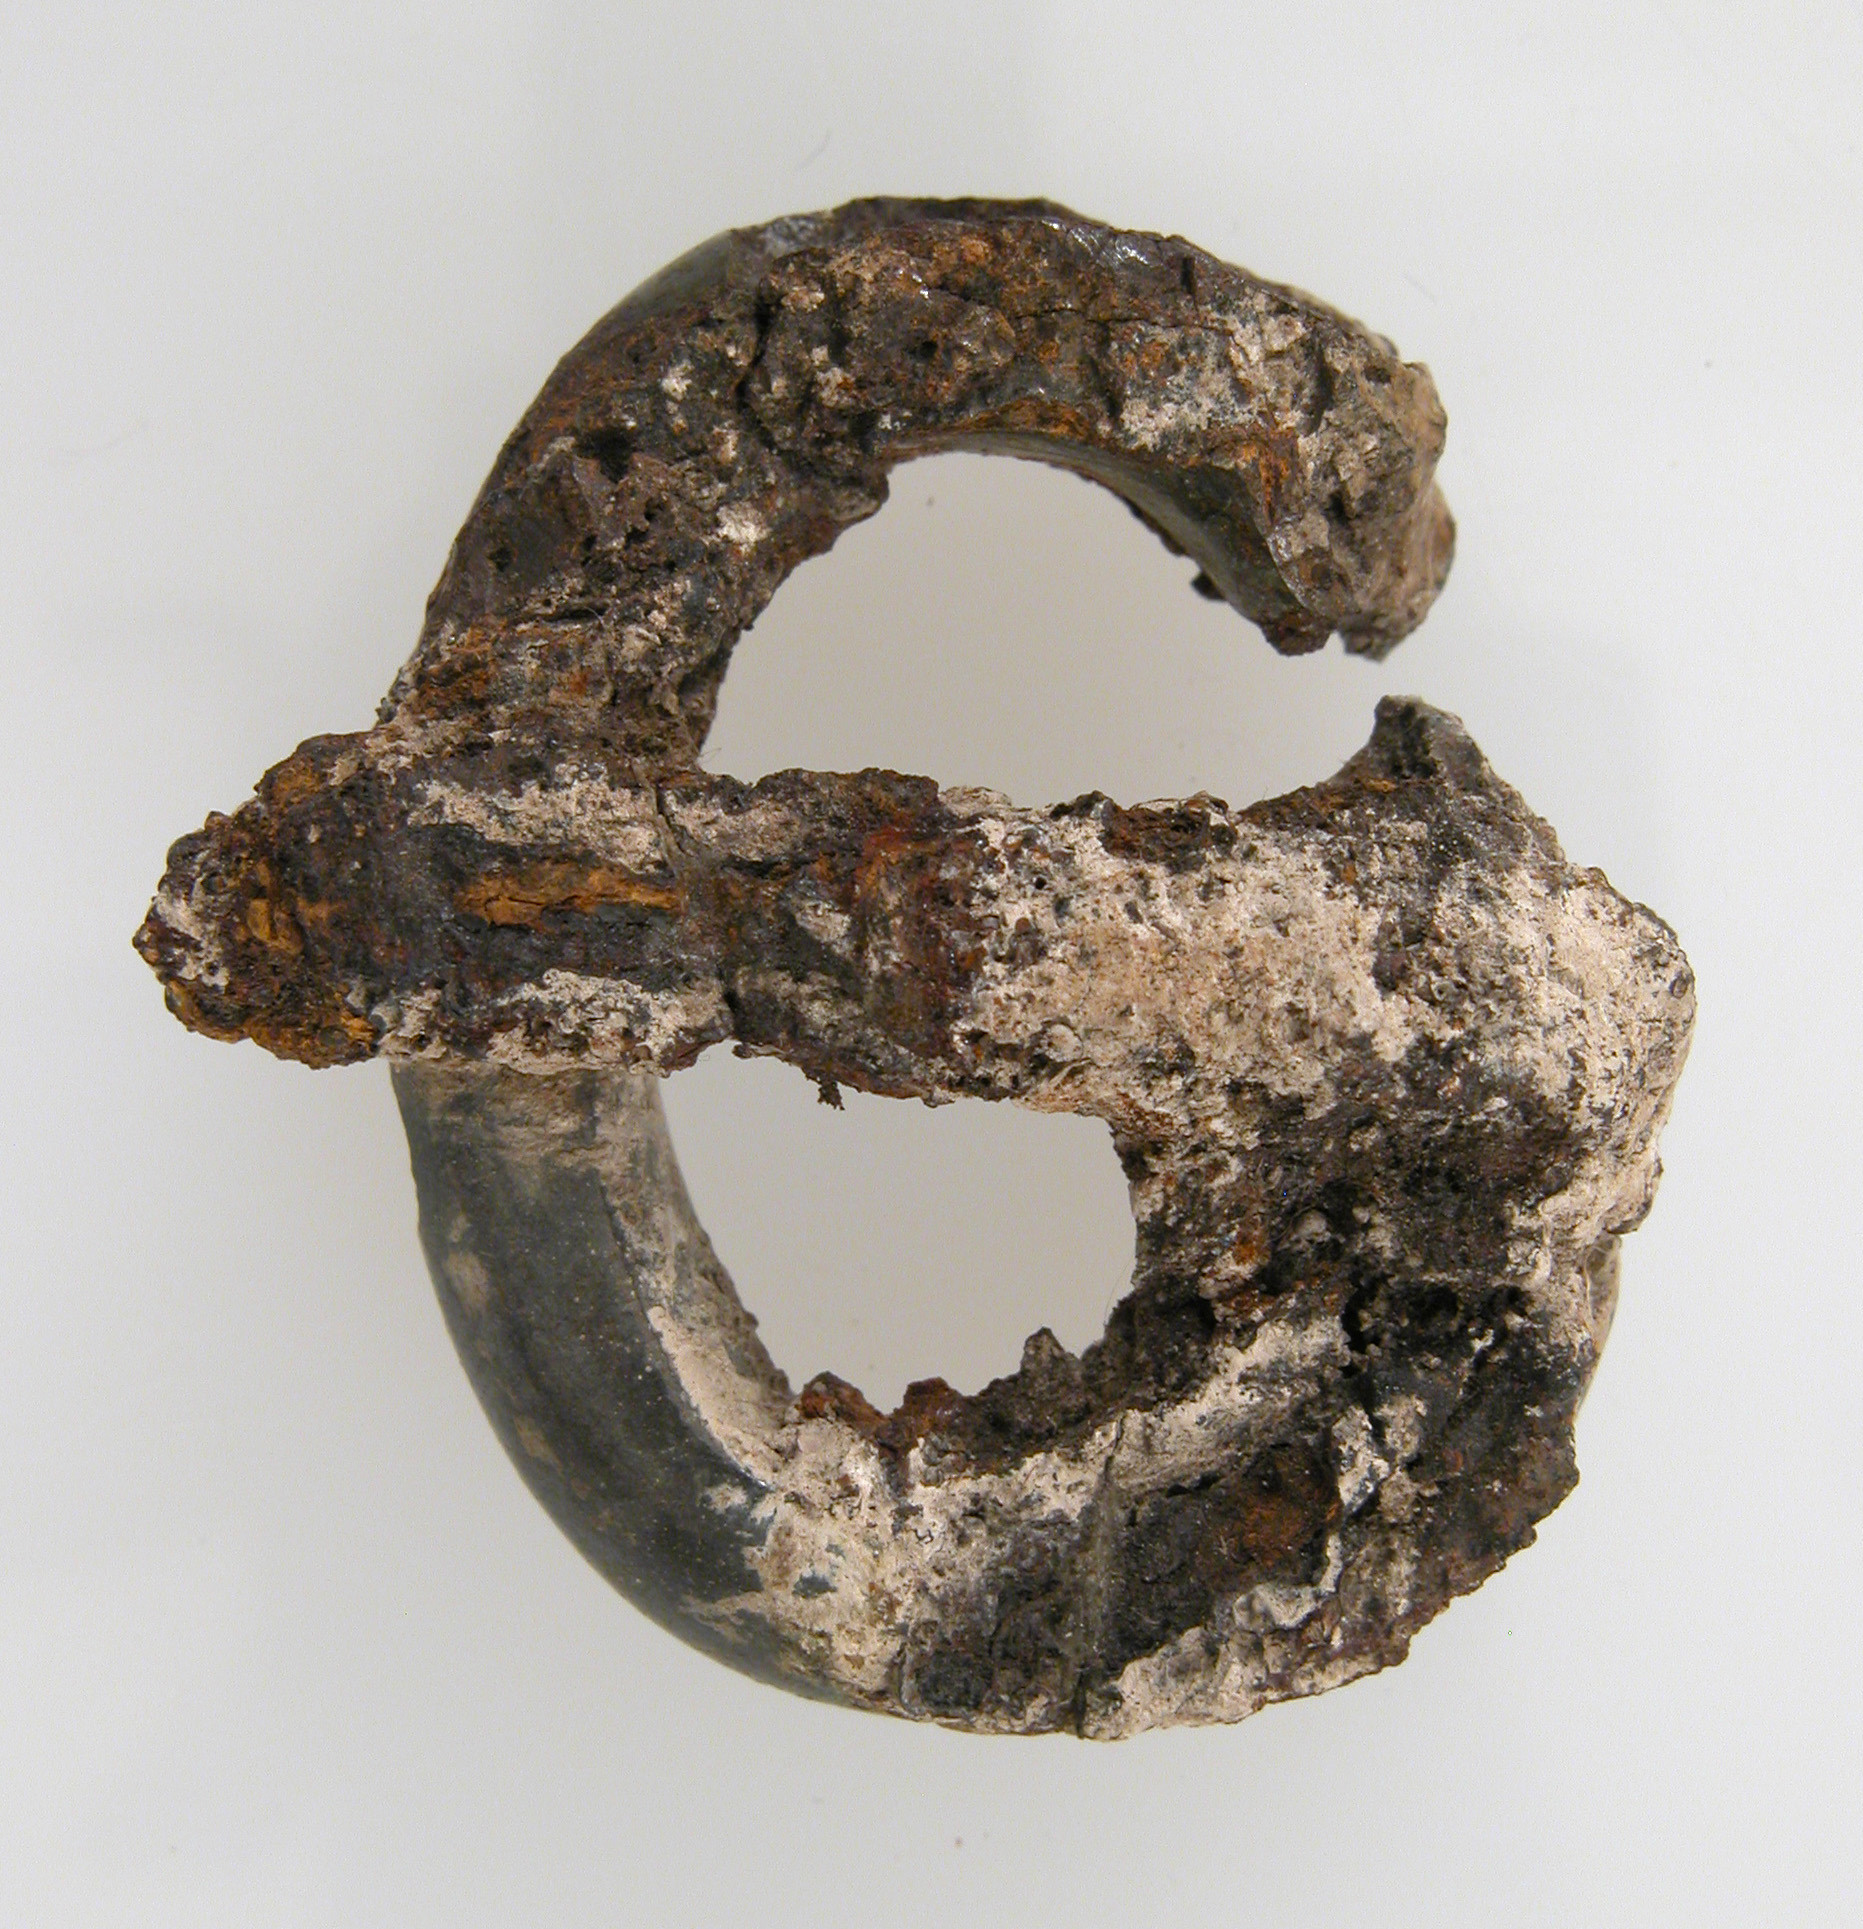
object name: buckle loop and tongue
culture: frankish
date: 501-700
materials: copper alloy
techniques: silvered